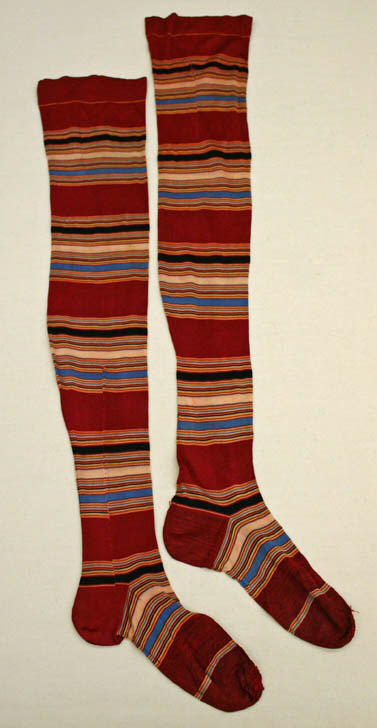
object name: stocking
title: Stockings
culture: american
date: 1867-1900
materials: silk